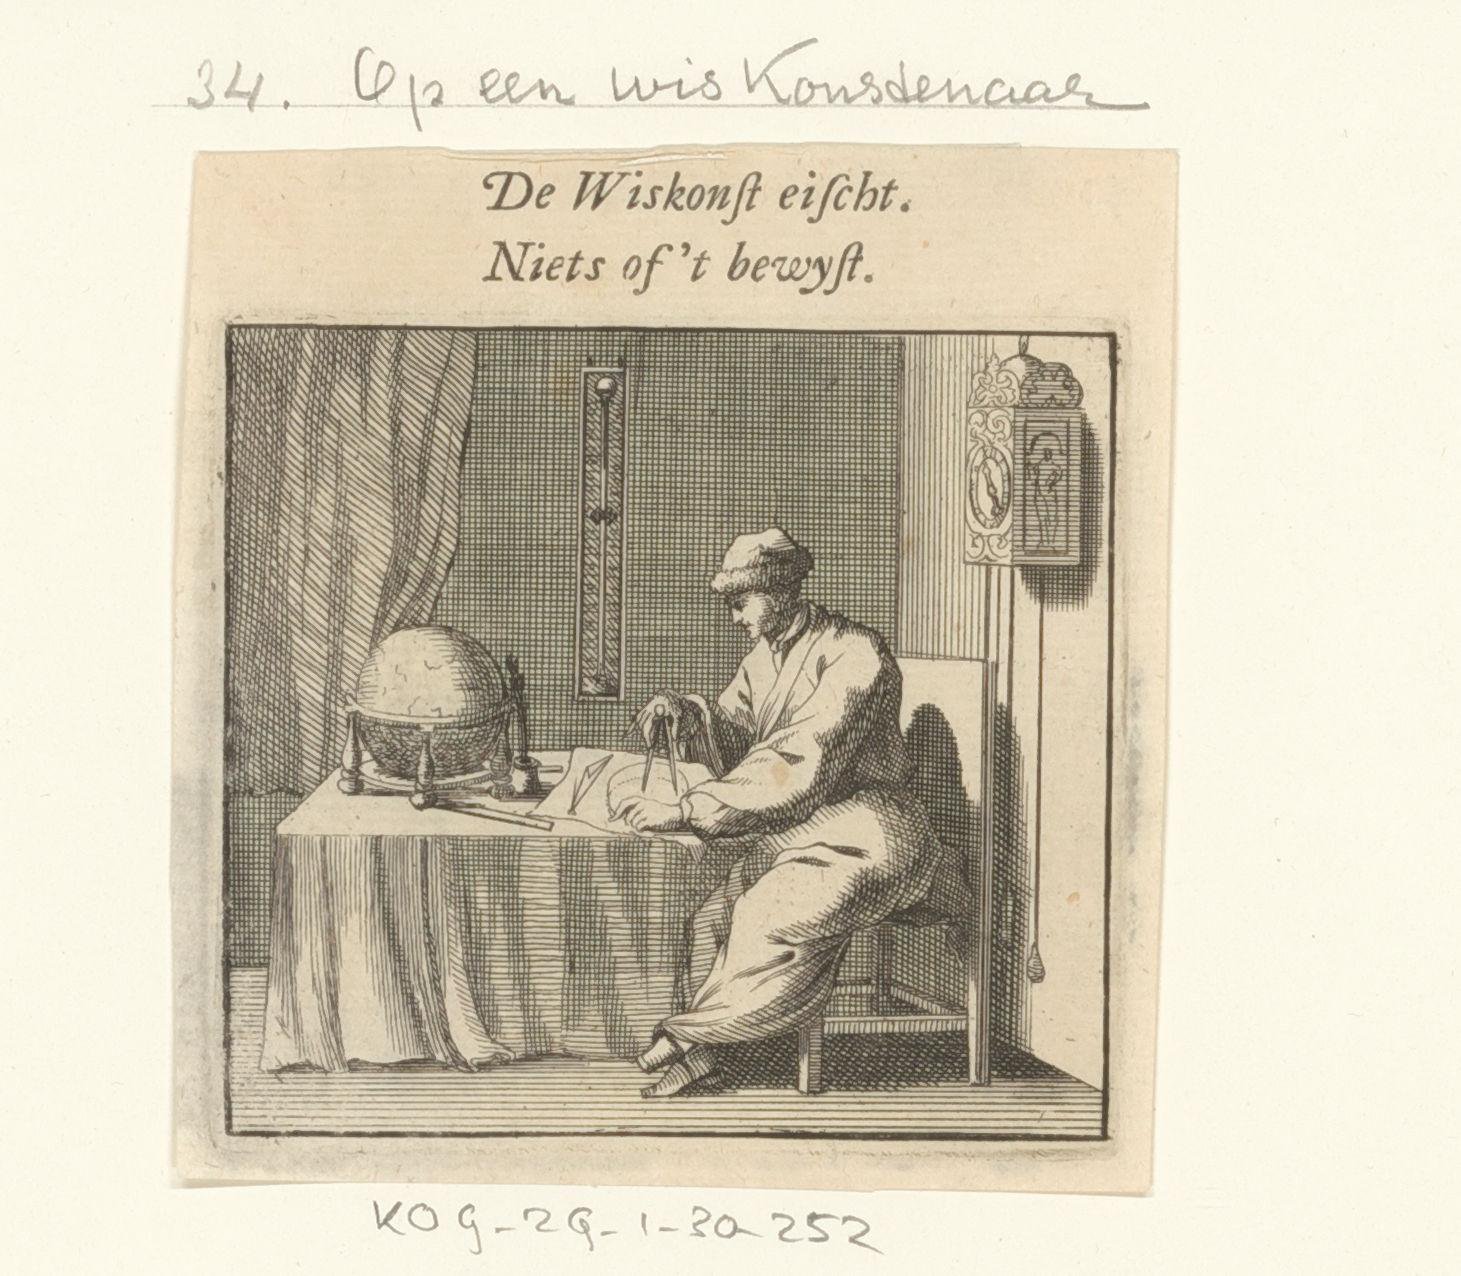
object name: print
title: Man kijkt met een sterrenkijker naar de sterren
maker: cornelis huyberts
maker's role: print maker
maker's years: 1669-1709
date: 1725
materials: paper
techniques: etching, letterpress printing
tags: drawing, measuring, calculating, mathematics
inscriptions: stamp, collector's mark: Lugt 1641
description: Prent uit: Graauwhart, Hendrik. Voorbeeldelyke zeede-lessen, genoomen uyt den eersten toestand des werelds (...). Amsterdam: Johannes Ratelband, 1725. Prent ook gebruikt voor eerdere en (1709) latere uitgave (1756, 1761 en 1764).